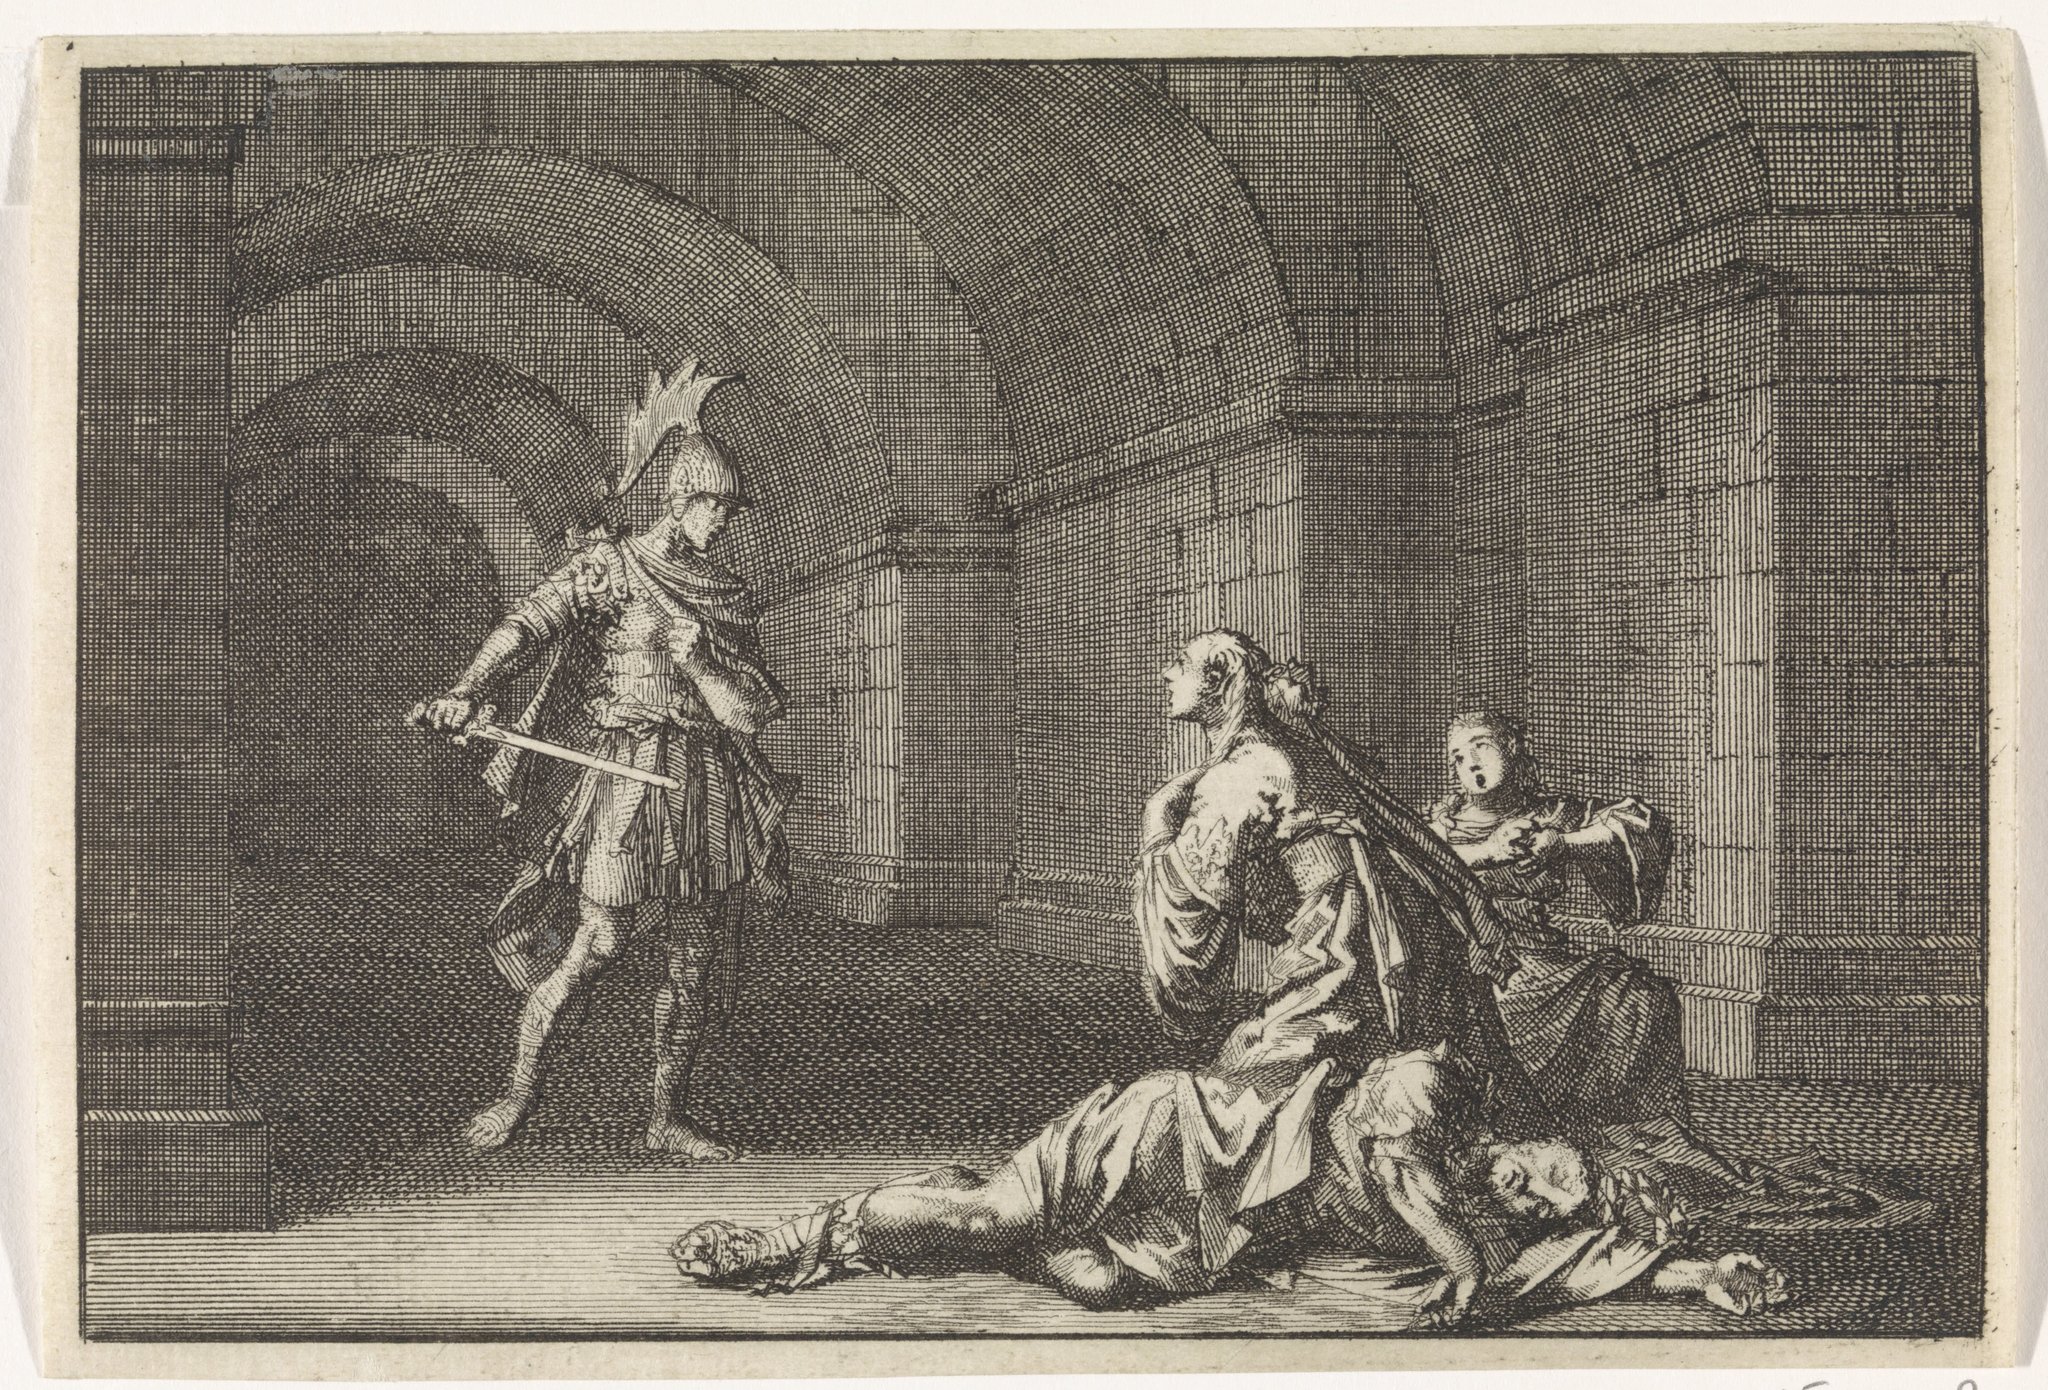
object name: print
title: Caesonia met haar dochter door Lupus gedood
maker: jan luyken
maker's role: draughtsman, print maker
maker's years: 1649-1712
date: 1704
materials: paper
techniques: etching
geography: amsterdam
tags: murder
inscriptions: collector's mark: Lugt 2228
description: Prent ook gebruikt als boekillustratie in: Josephus, Flavius. Alle de Werken, 2 delen. Amsterdam: Pieter Mortier, 1704, dl. 1, p. 460.